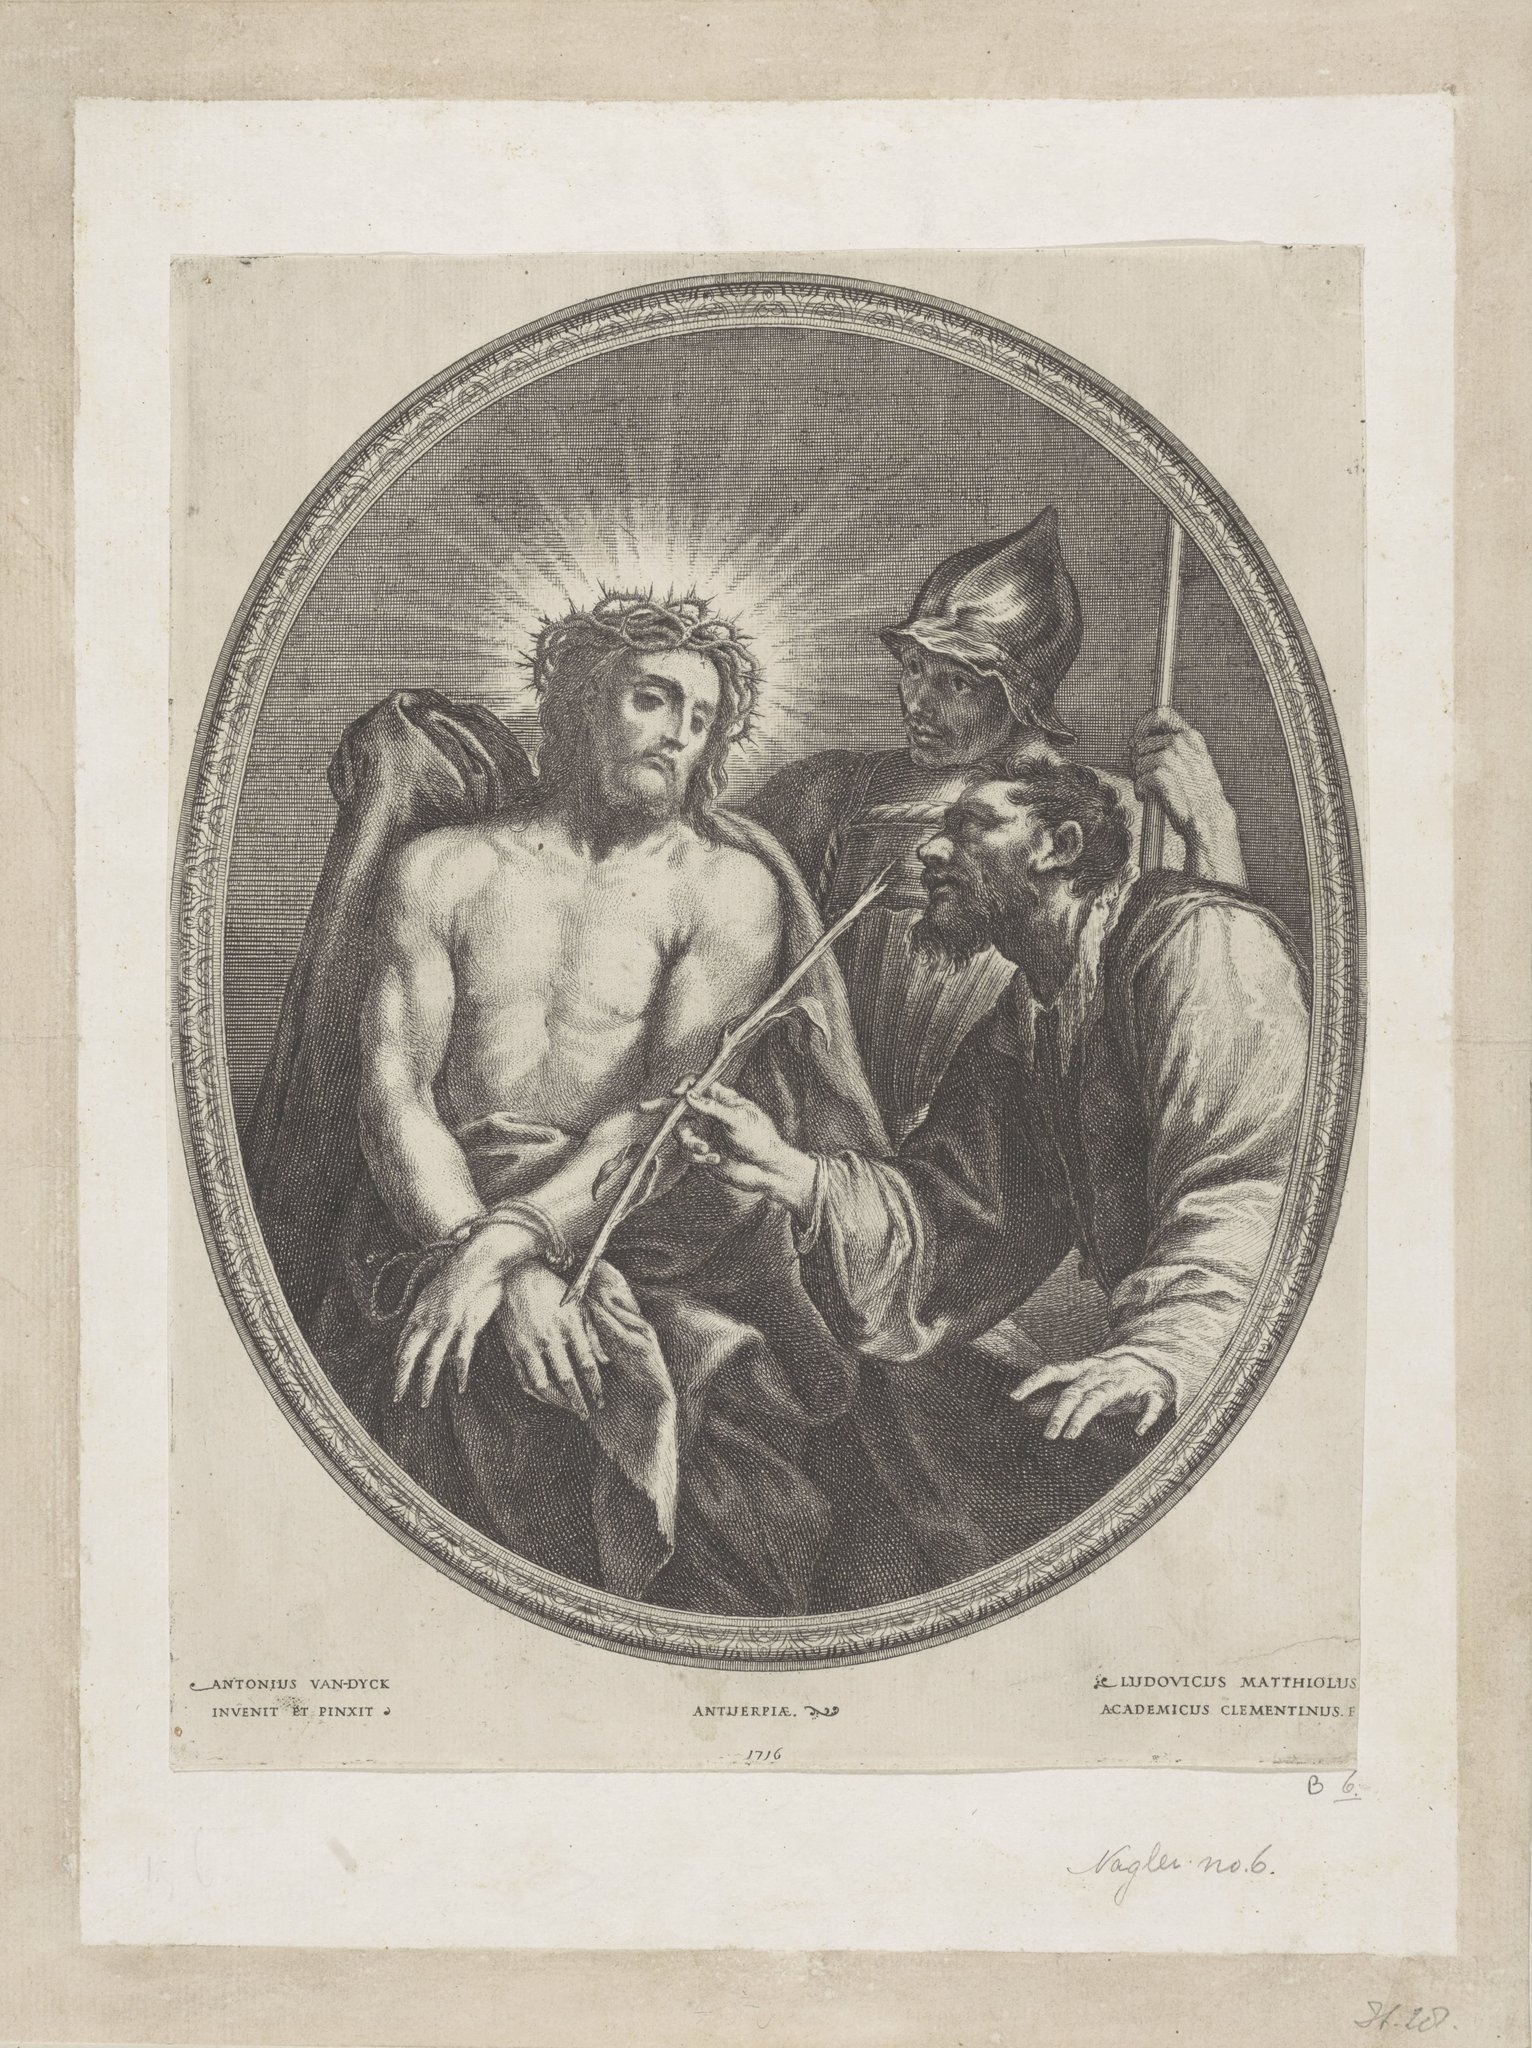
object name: print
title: Bespotting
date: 1716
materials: paper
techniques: etching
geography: italy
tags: mockings of christ, who may be blindfolded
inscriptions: collector's mark: Lugt 2165 of 2166, inscription: ‘B Bii[...]’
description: Christus zit met de doornenkroon op zijn hoofd. Een soldaat en een man bieden hem een mantel en een rietstaf aan. Voorstelling gevat in een ovale sierlijst.